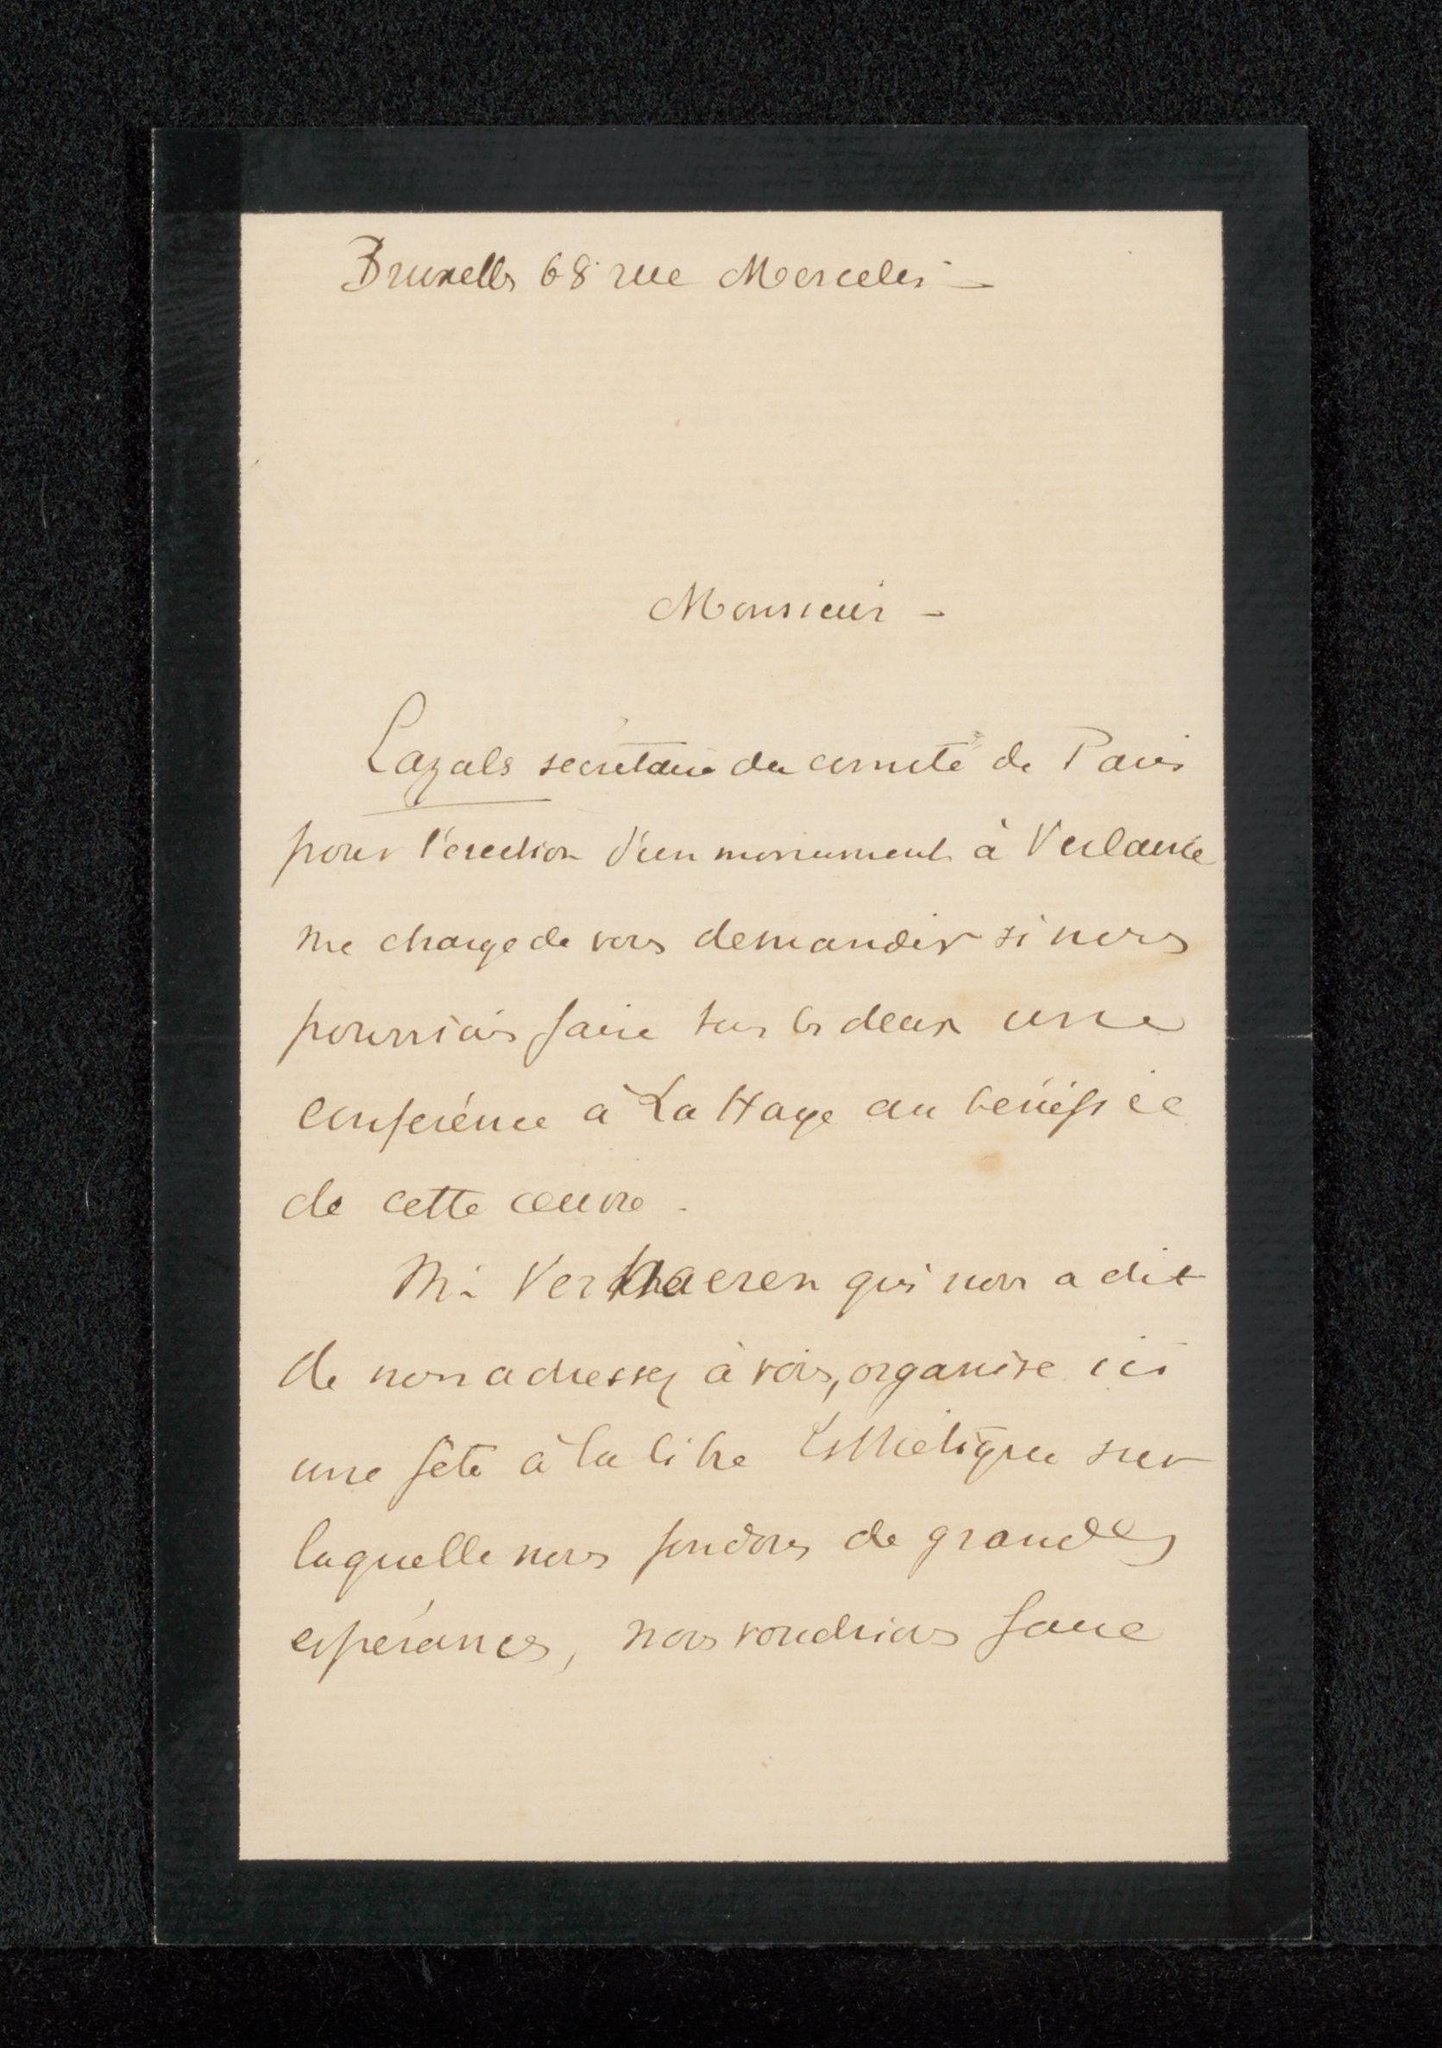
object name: letter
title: Brief aan Philip Zilcken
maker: burggraaf de colleville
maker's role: burggraaf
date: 1897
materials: ink, paper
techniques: pen, writing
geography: brussels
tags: print maker, frédéric-auguste cazals, paris, paul verlaine, emile verhaeren, painter, draughtsman, philip zilcken, the hague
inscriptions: collector's mark: ‘RPK’